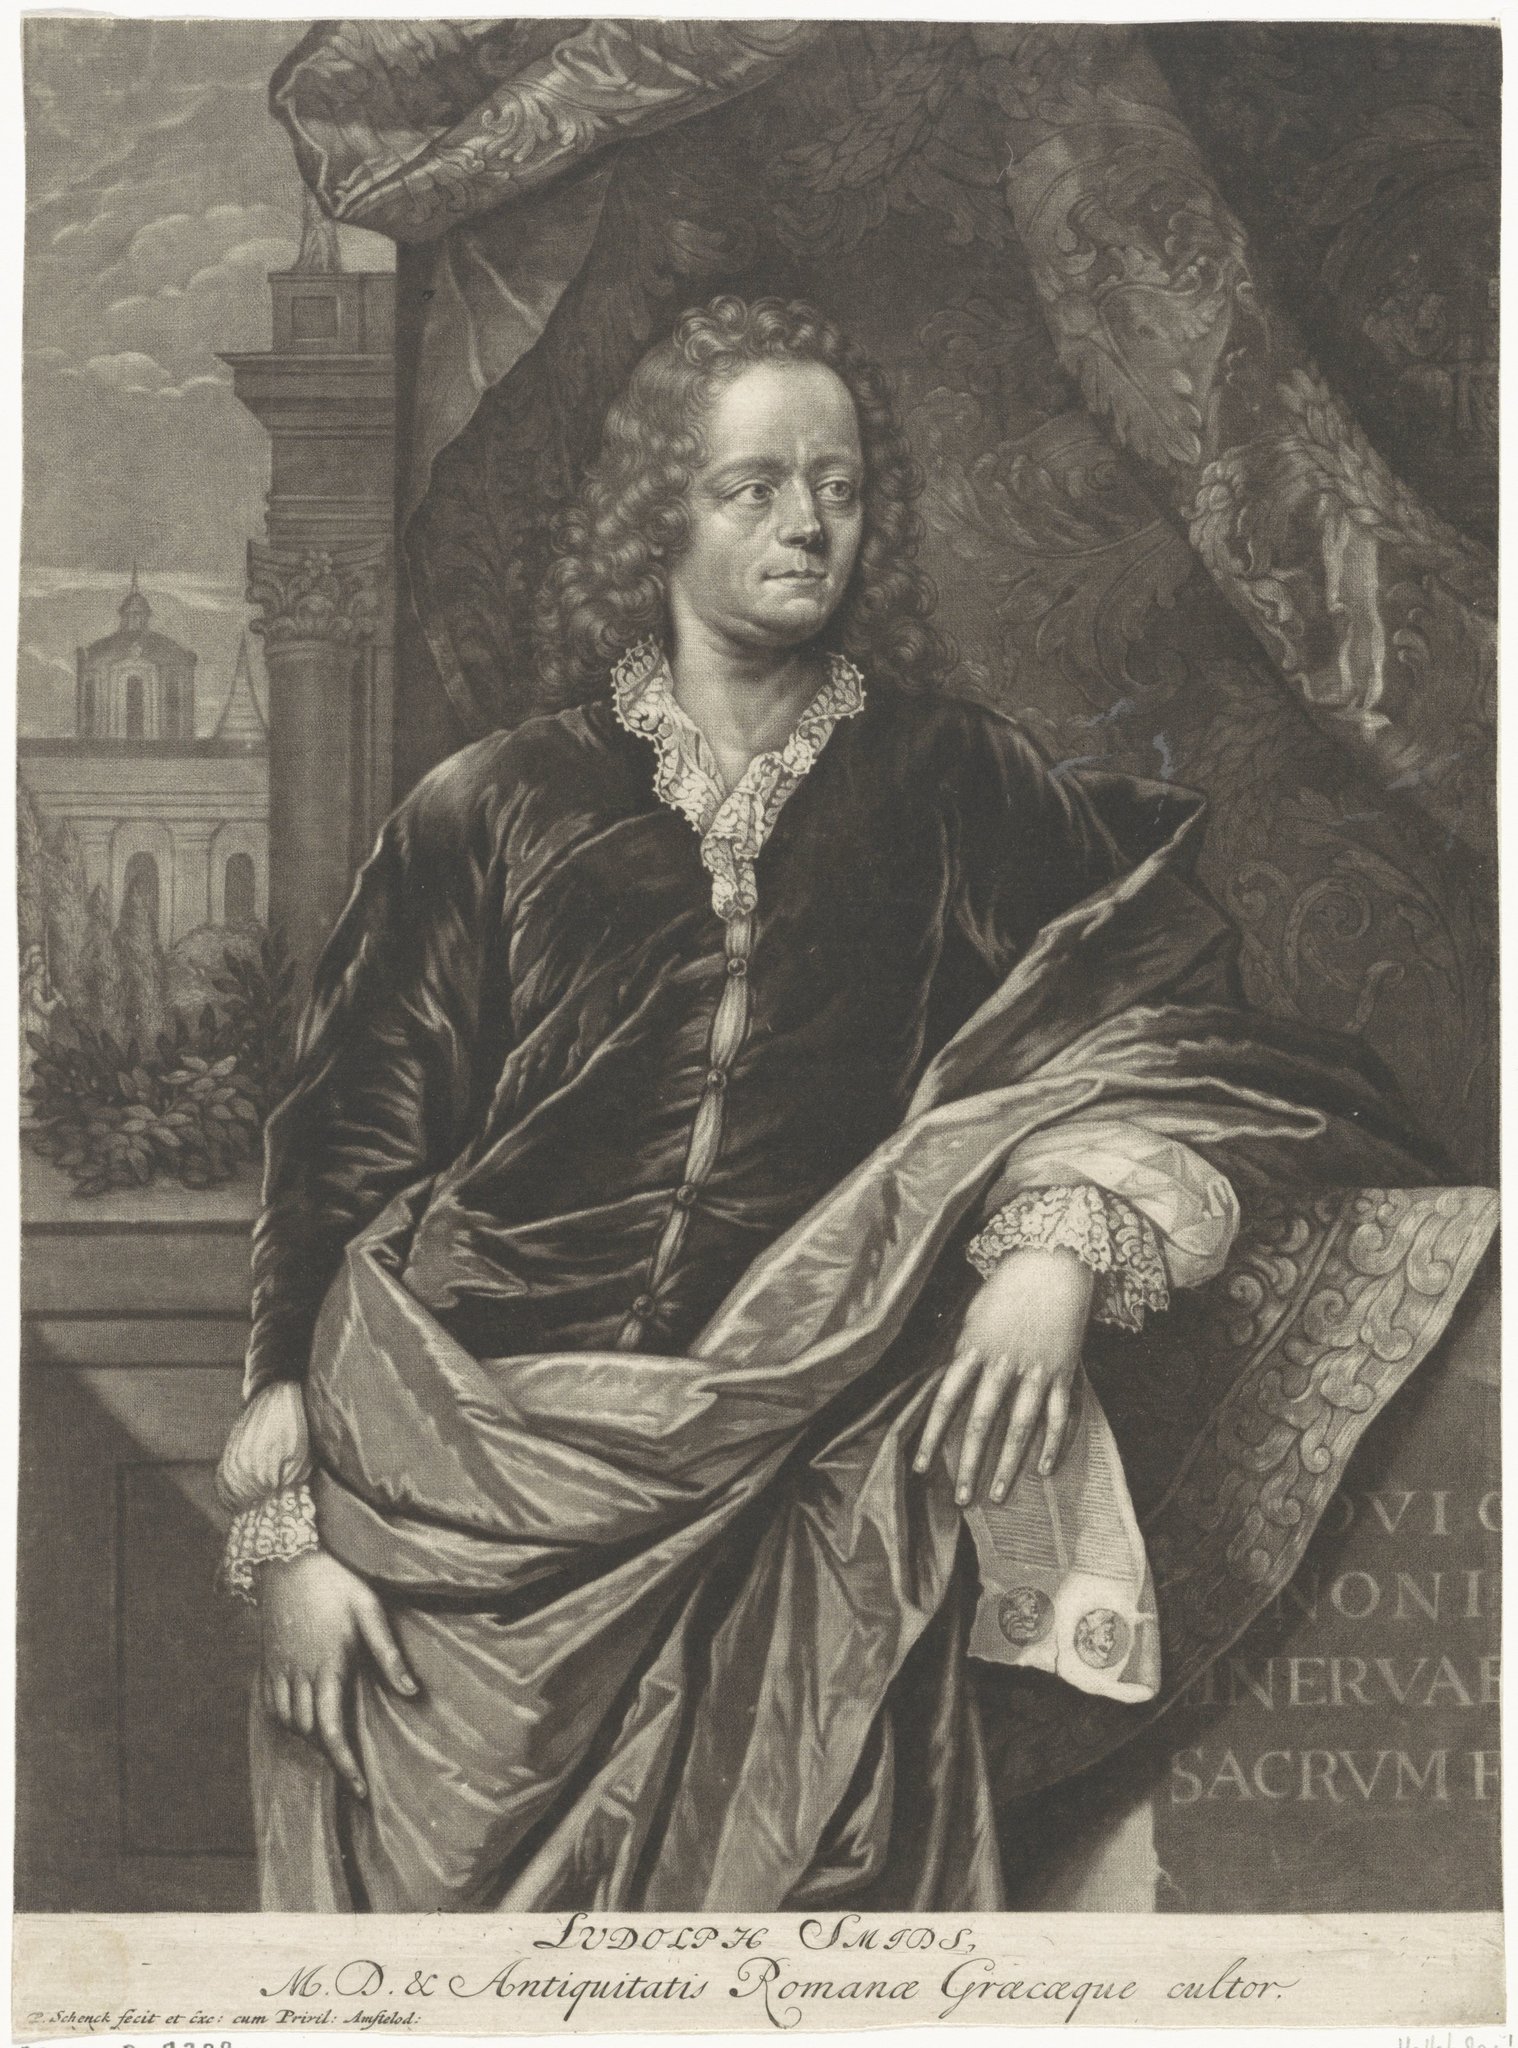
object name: print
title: Portret van Ludolph Smids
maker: pieter schenk (i)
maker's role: print maker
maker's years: 1660-1711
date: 1670-1713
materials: paper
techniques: engraving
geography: amsterdam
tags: amsterdam, ludolph smids, letter, envelope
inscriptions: collector's mark: Lugt 240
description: De dichter, oudheidkundige en arts Ludolph Smids met in zijn hand een brief waarop twee medaillons waarin klassieke bustes. Achter hem een draperie en een gebouw.